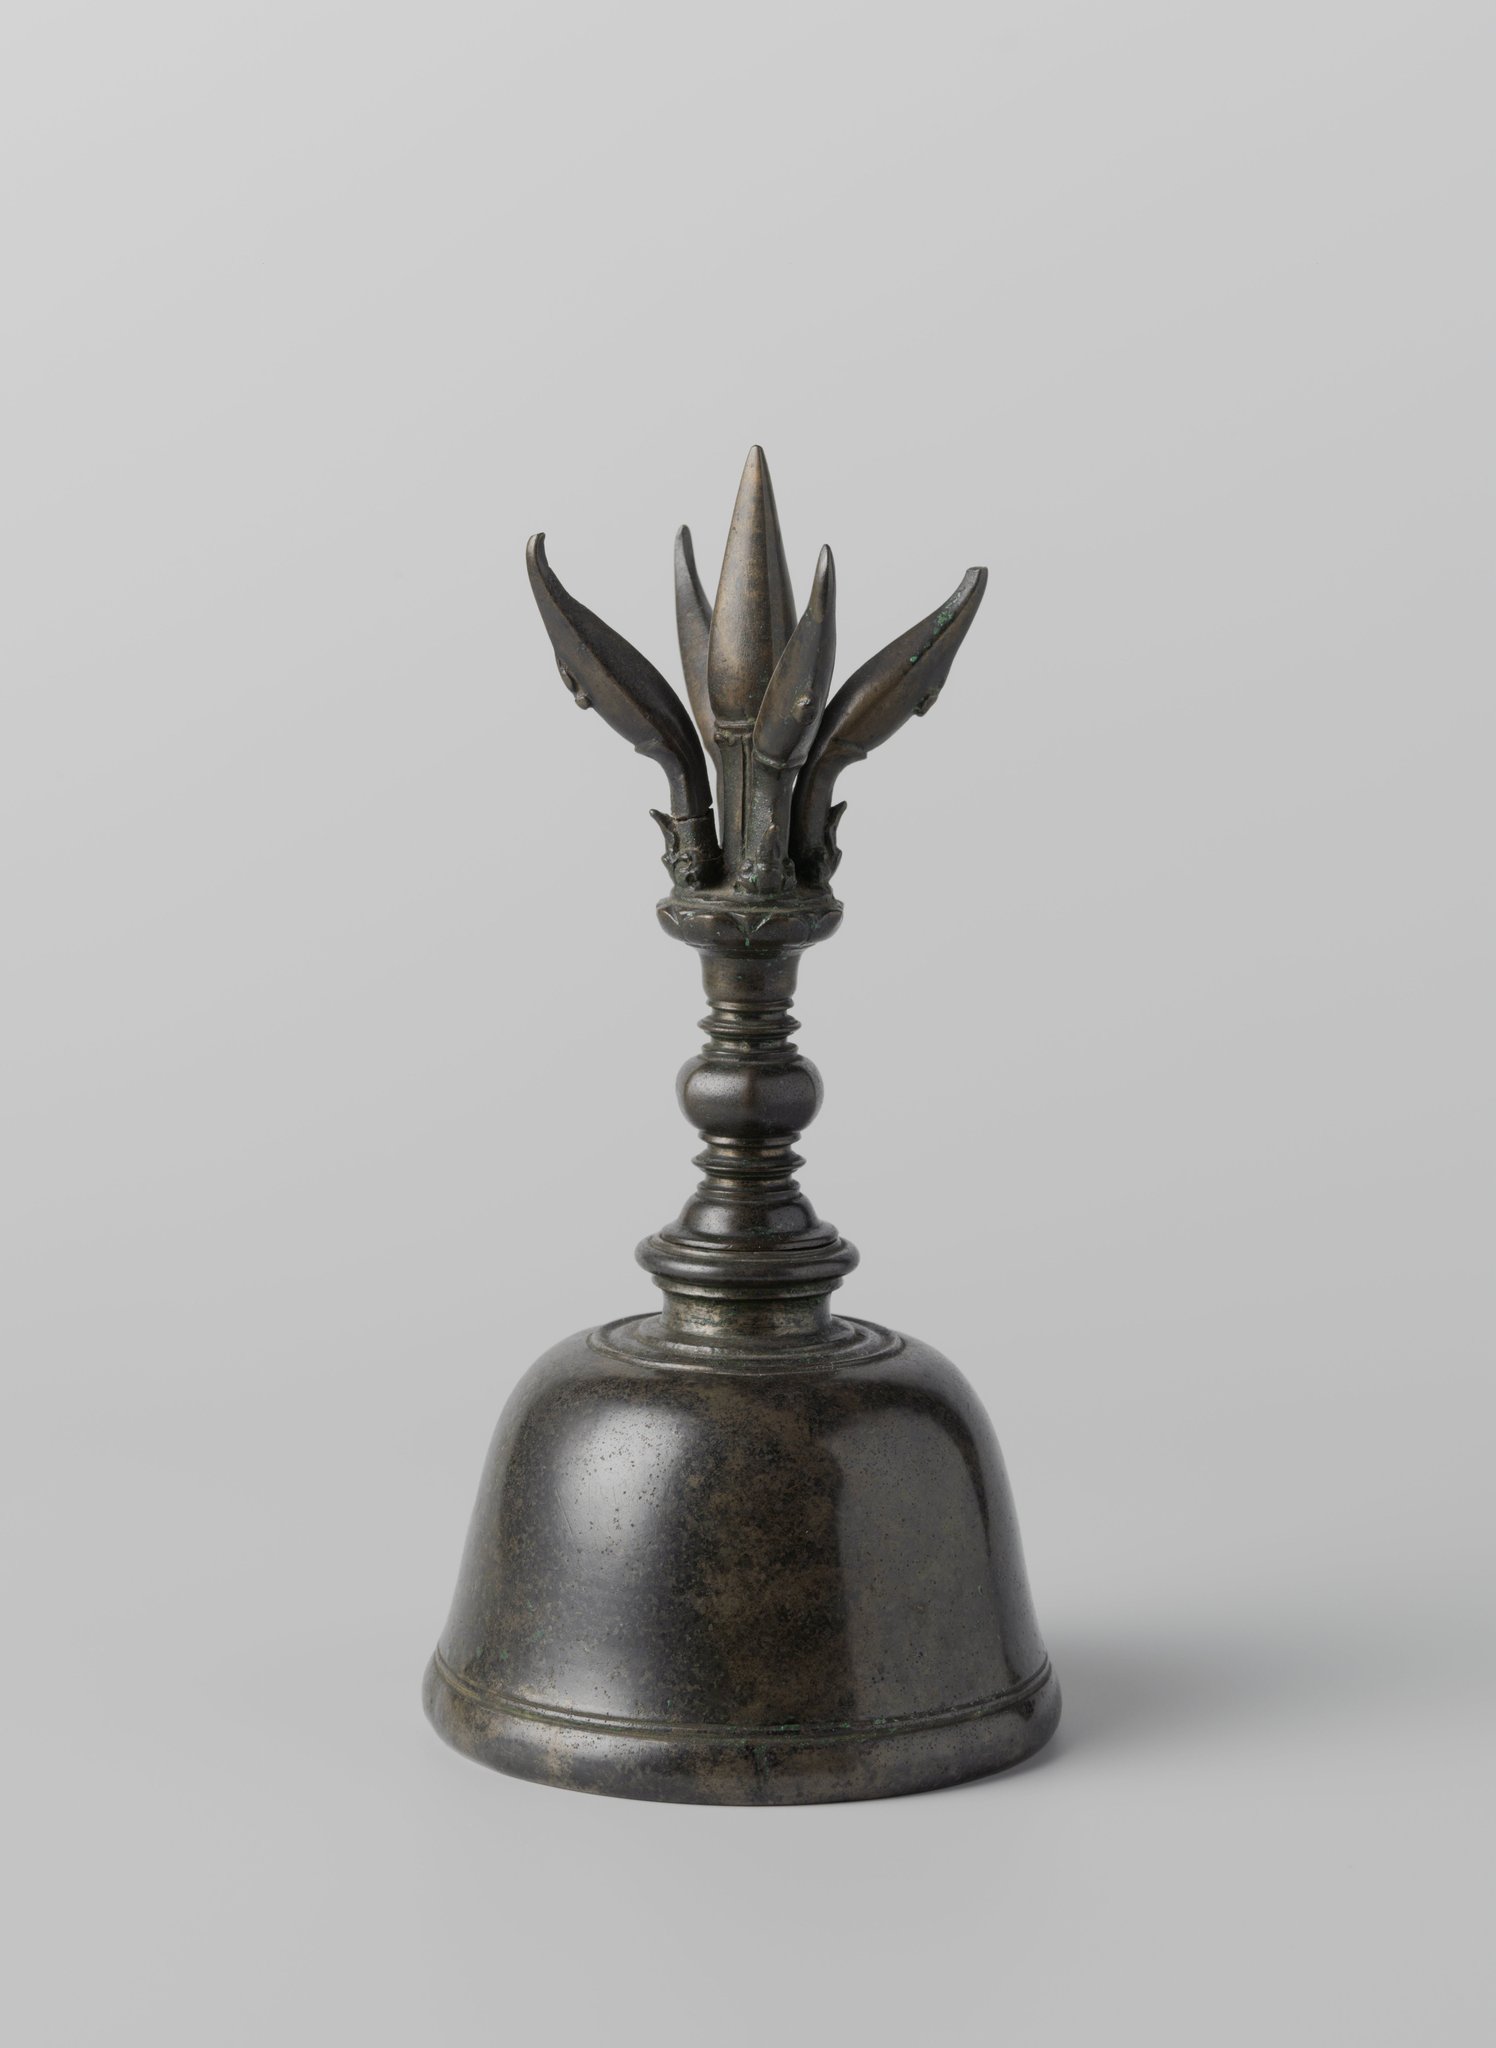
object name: ghanta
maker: Anonymous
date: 900-1600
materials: bronze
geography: east java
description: Priest's bell. Crowned with a vajra. Indonesia, East Java. 13th - 15th century. Bronze. Priest's bells of the East Java period are simpler than those of the Central Java period. The tips of the vajra point out; in the Central Java period, they turn inward.